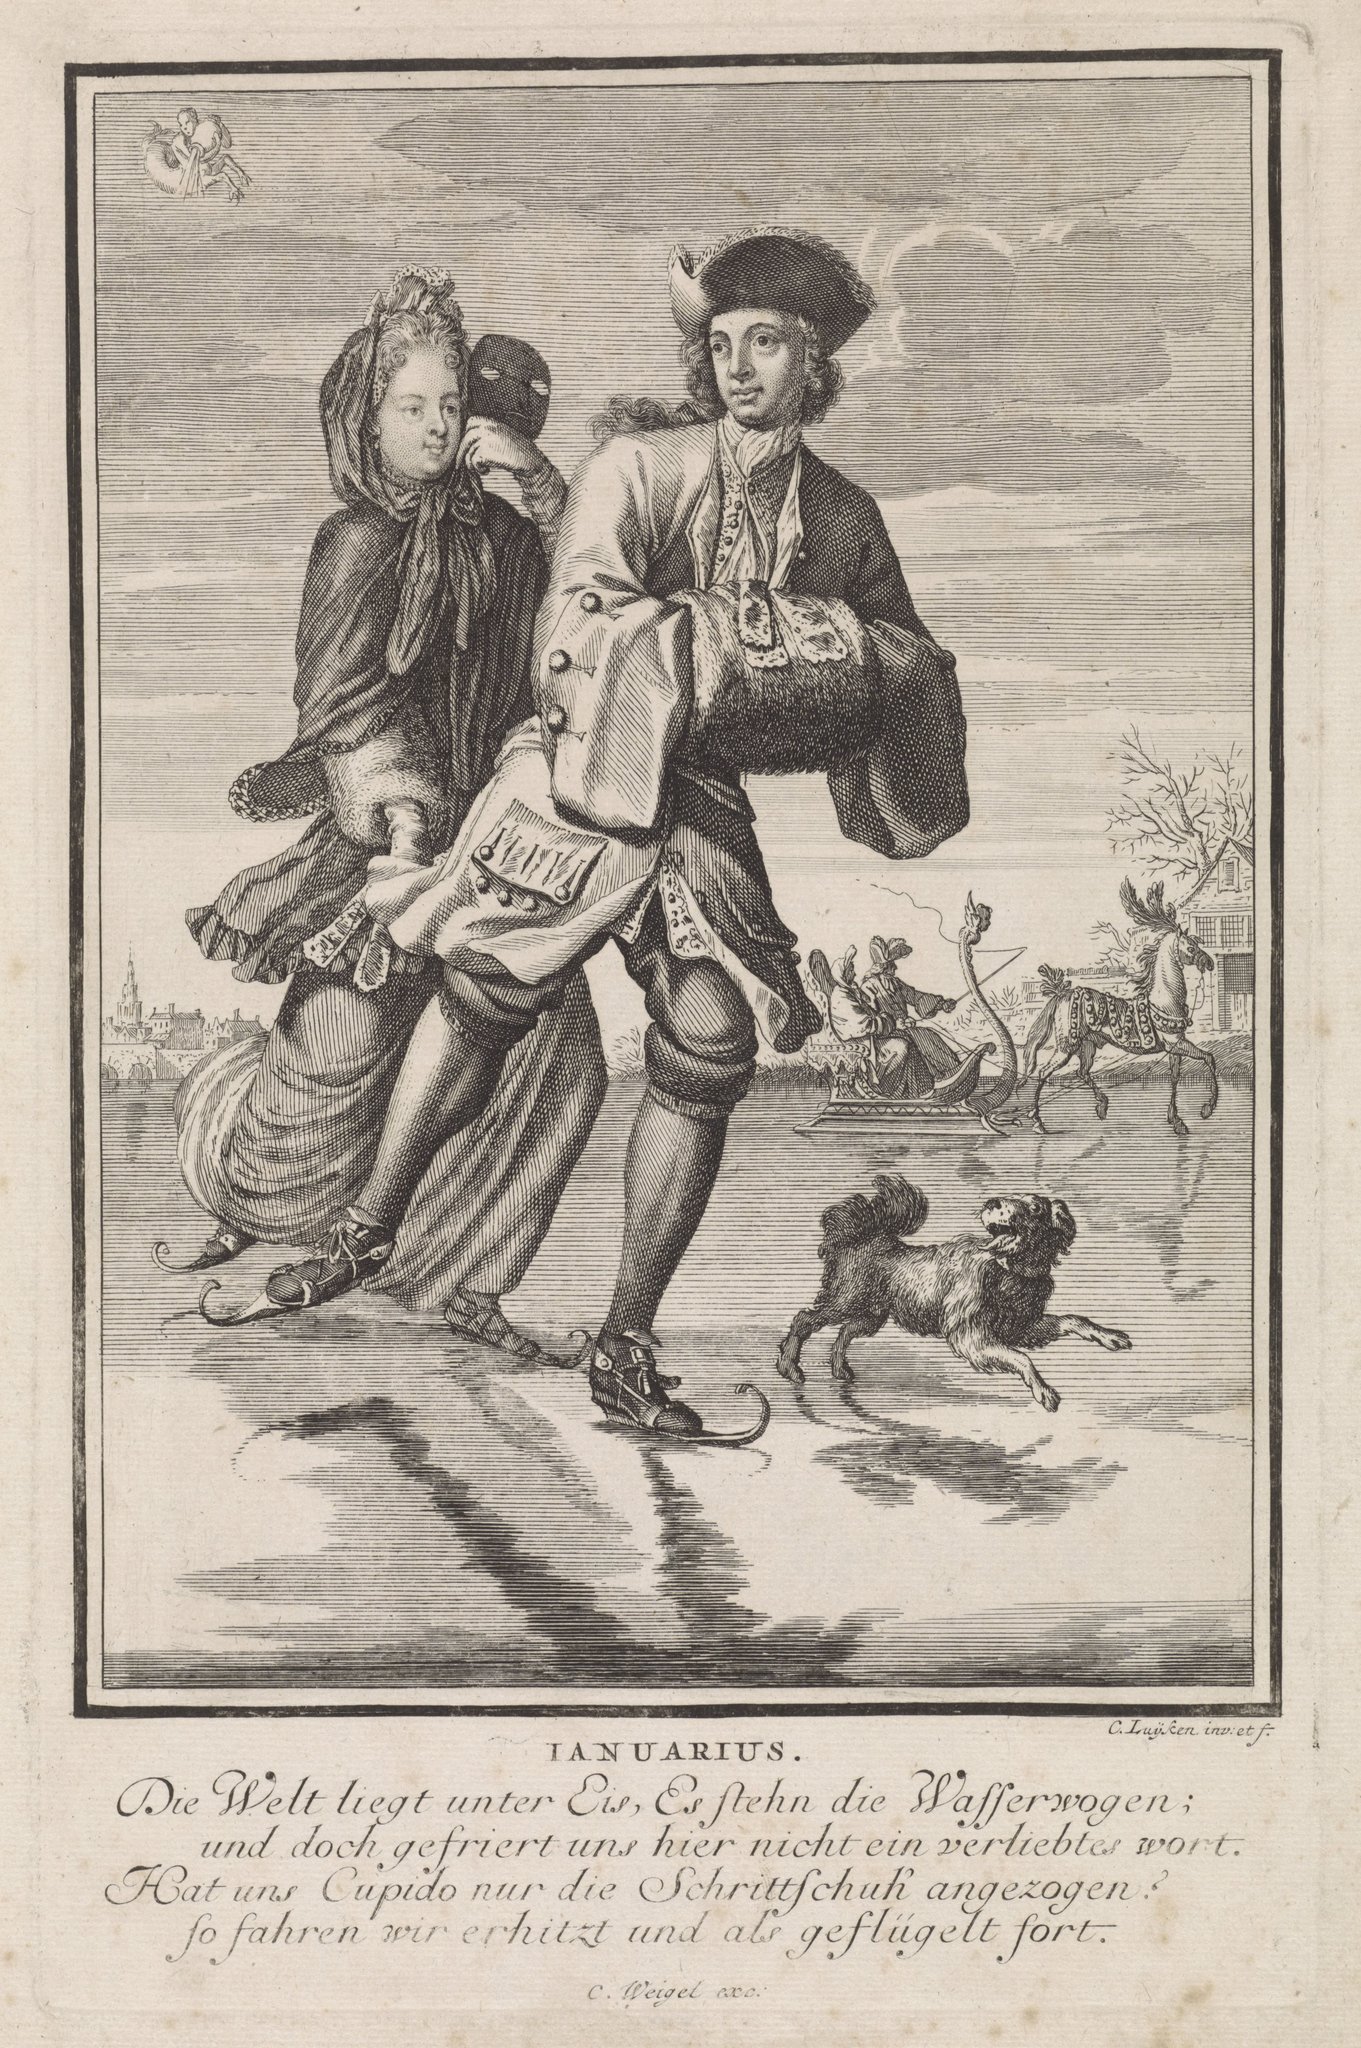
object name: print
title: Januari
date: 1698-1702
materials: paper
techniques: engraving, etching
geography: nuremberg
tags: january and its 'labours', skates (winter sports), sledge, sleigh (winter sports), aquarius (zodiacal sign of january), january; 'gennaro' (ripa), landscape symbolizing january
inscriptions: collector's mark: Lugt 2228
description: De maand januari. Een paar schaatst op een bevroren kanaal. Een hond rent achter hen aan. Op de achtergrond een stad en een paar in een slede getrokken door een paard. De prent heeft een Duits onderschrift van vier regels over de maand januari.